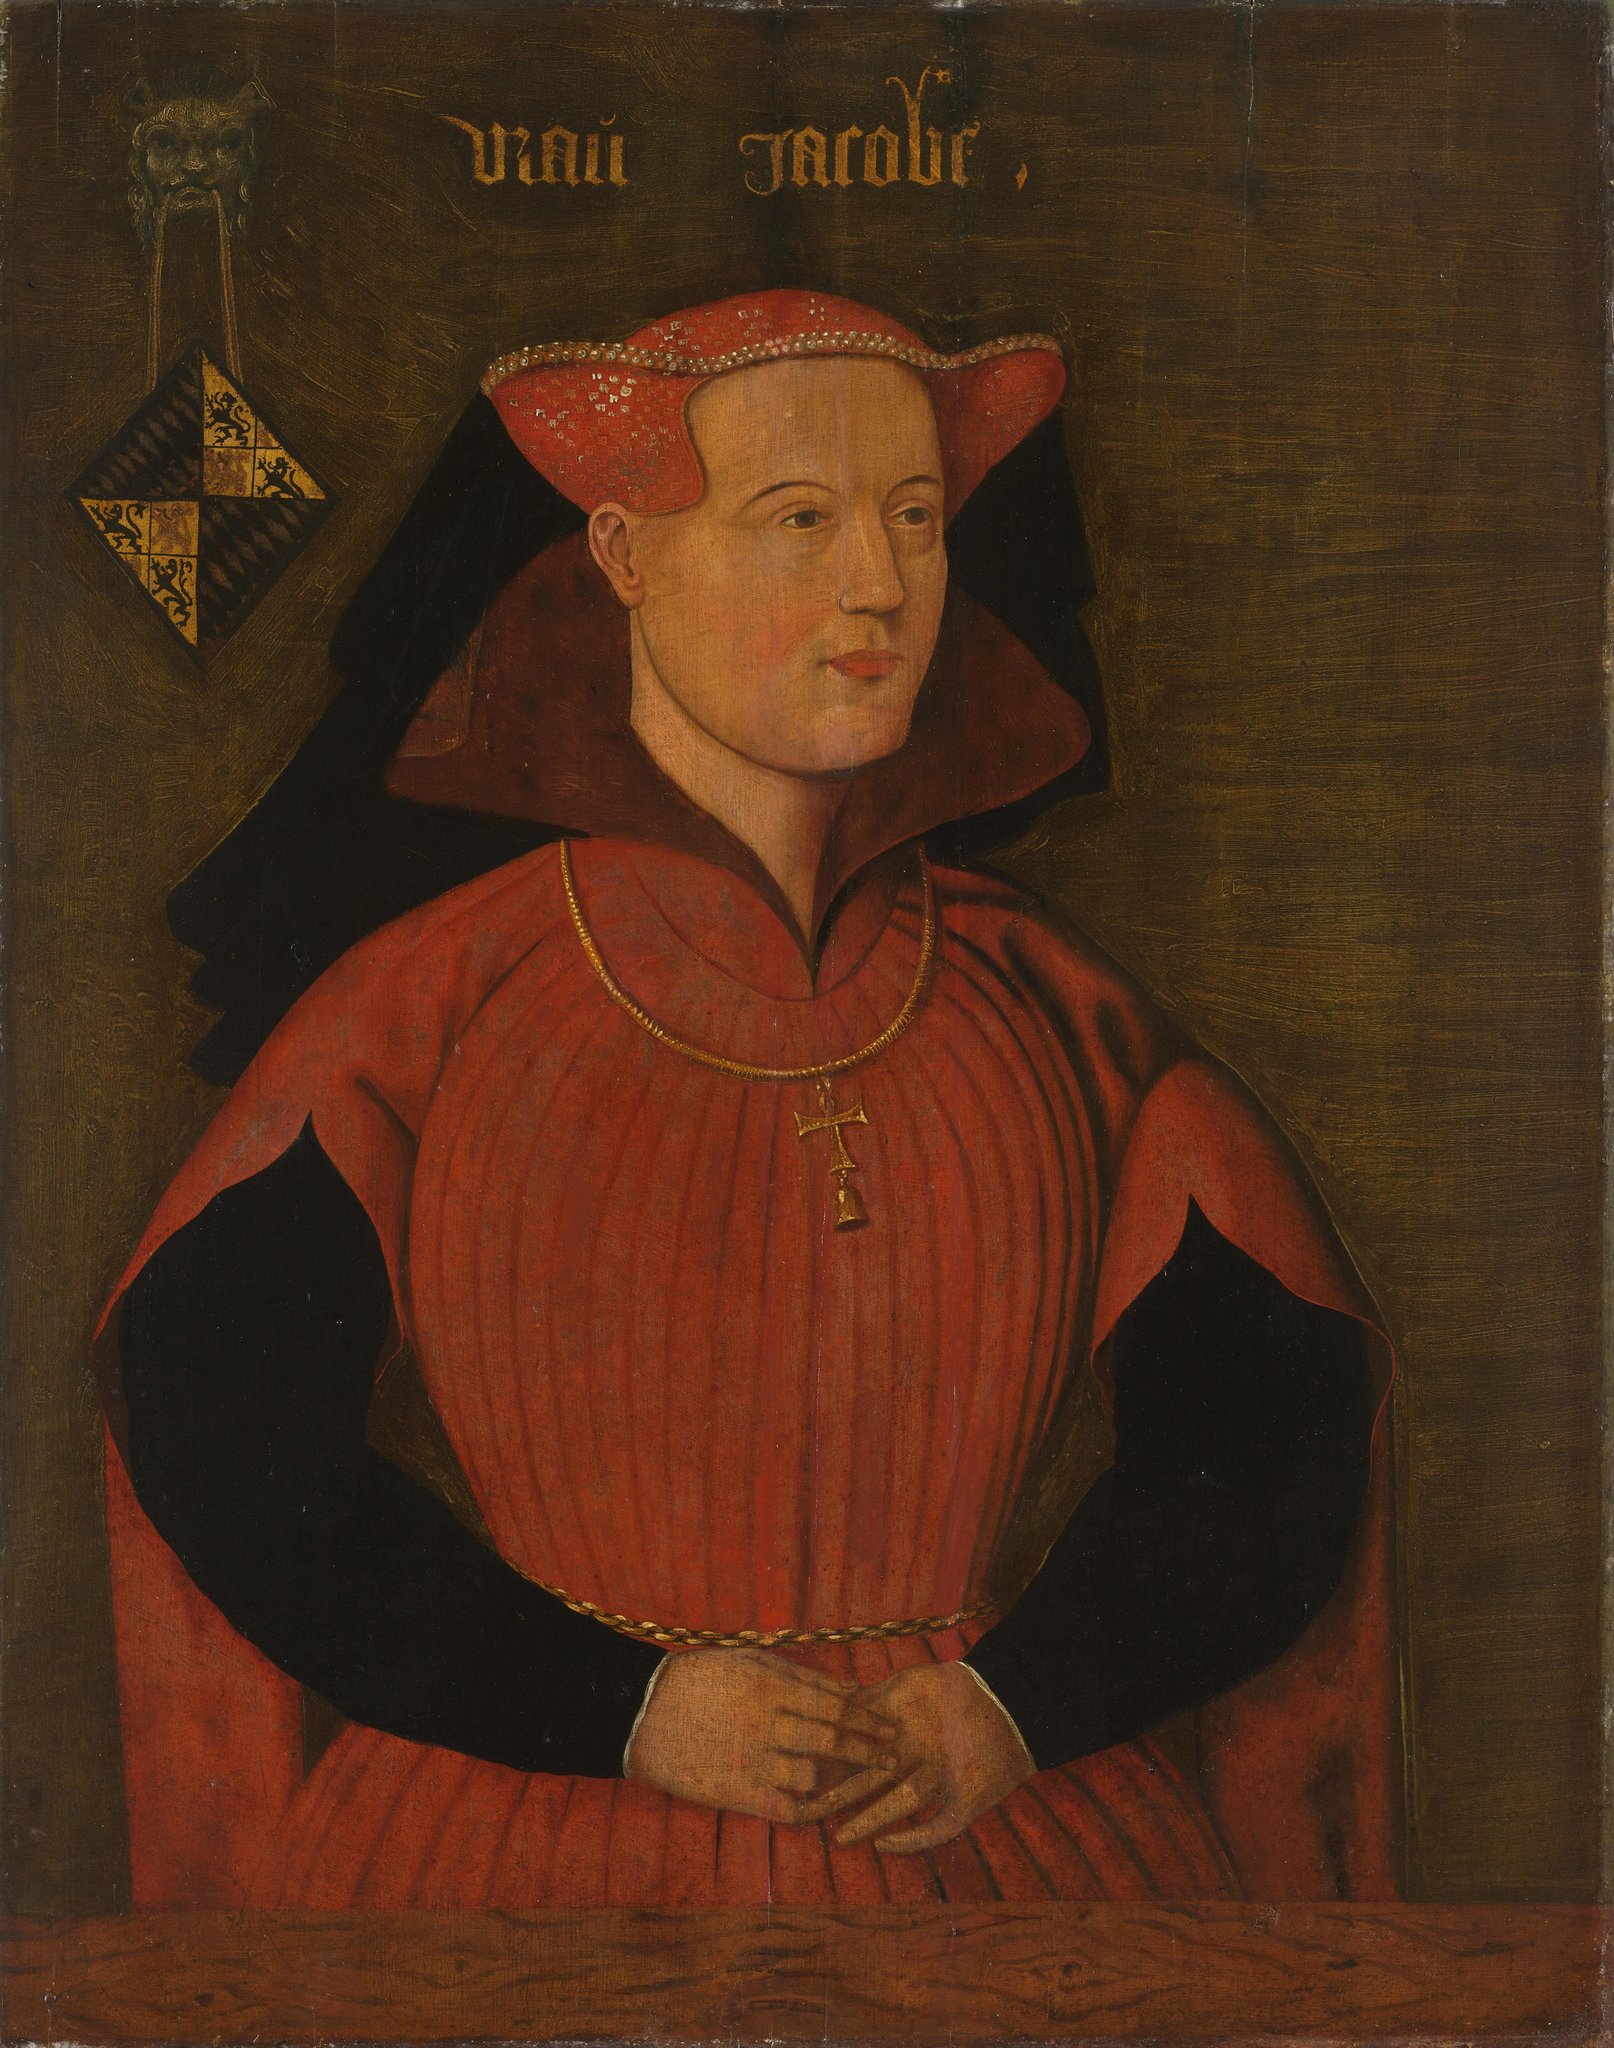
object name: painting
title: Portrait of Jacoba of Bavaria, Countess of Holland and Zeeland (Jacqueline, Countess of Hainaut)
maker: Anonymous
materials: oil, panel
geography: northern netherlands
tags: jacoba of bavaria (countess of hainaut), historical persons - bb - woman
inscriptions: inscription, top centre: ‘vrau jacobe.’, coat of arms, upper left: quartered, 1 and 4, diagonal silver lozenges on a blue field (Bavaria); 2 and 3, quartered, i and iv, a black lion rampant on a gold field (Hainaut), ii and iii, a red lion rampant on a gold field (Holland)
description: Portret van Jacoba van Beieren (1401-36), gravin van Holland en Zeeland. Ten halven lijve, naar rechts. Om de hals een ketting met het kruis van de Orde van St. Antonius. Linksboven het familiewapen. Zestiende-eeuwse kopie naar het origineel uit ca. 1435. Pendant van SK-A-499.